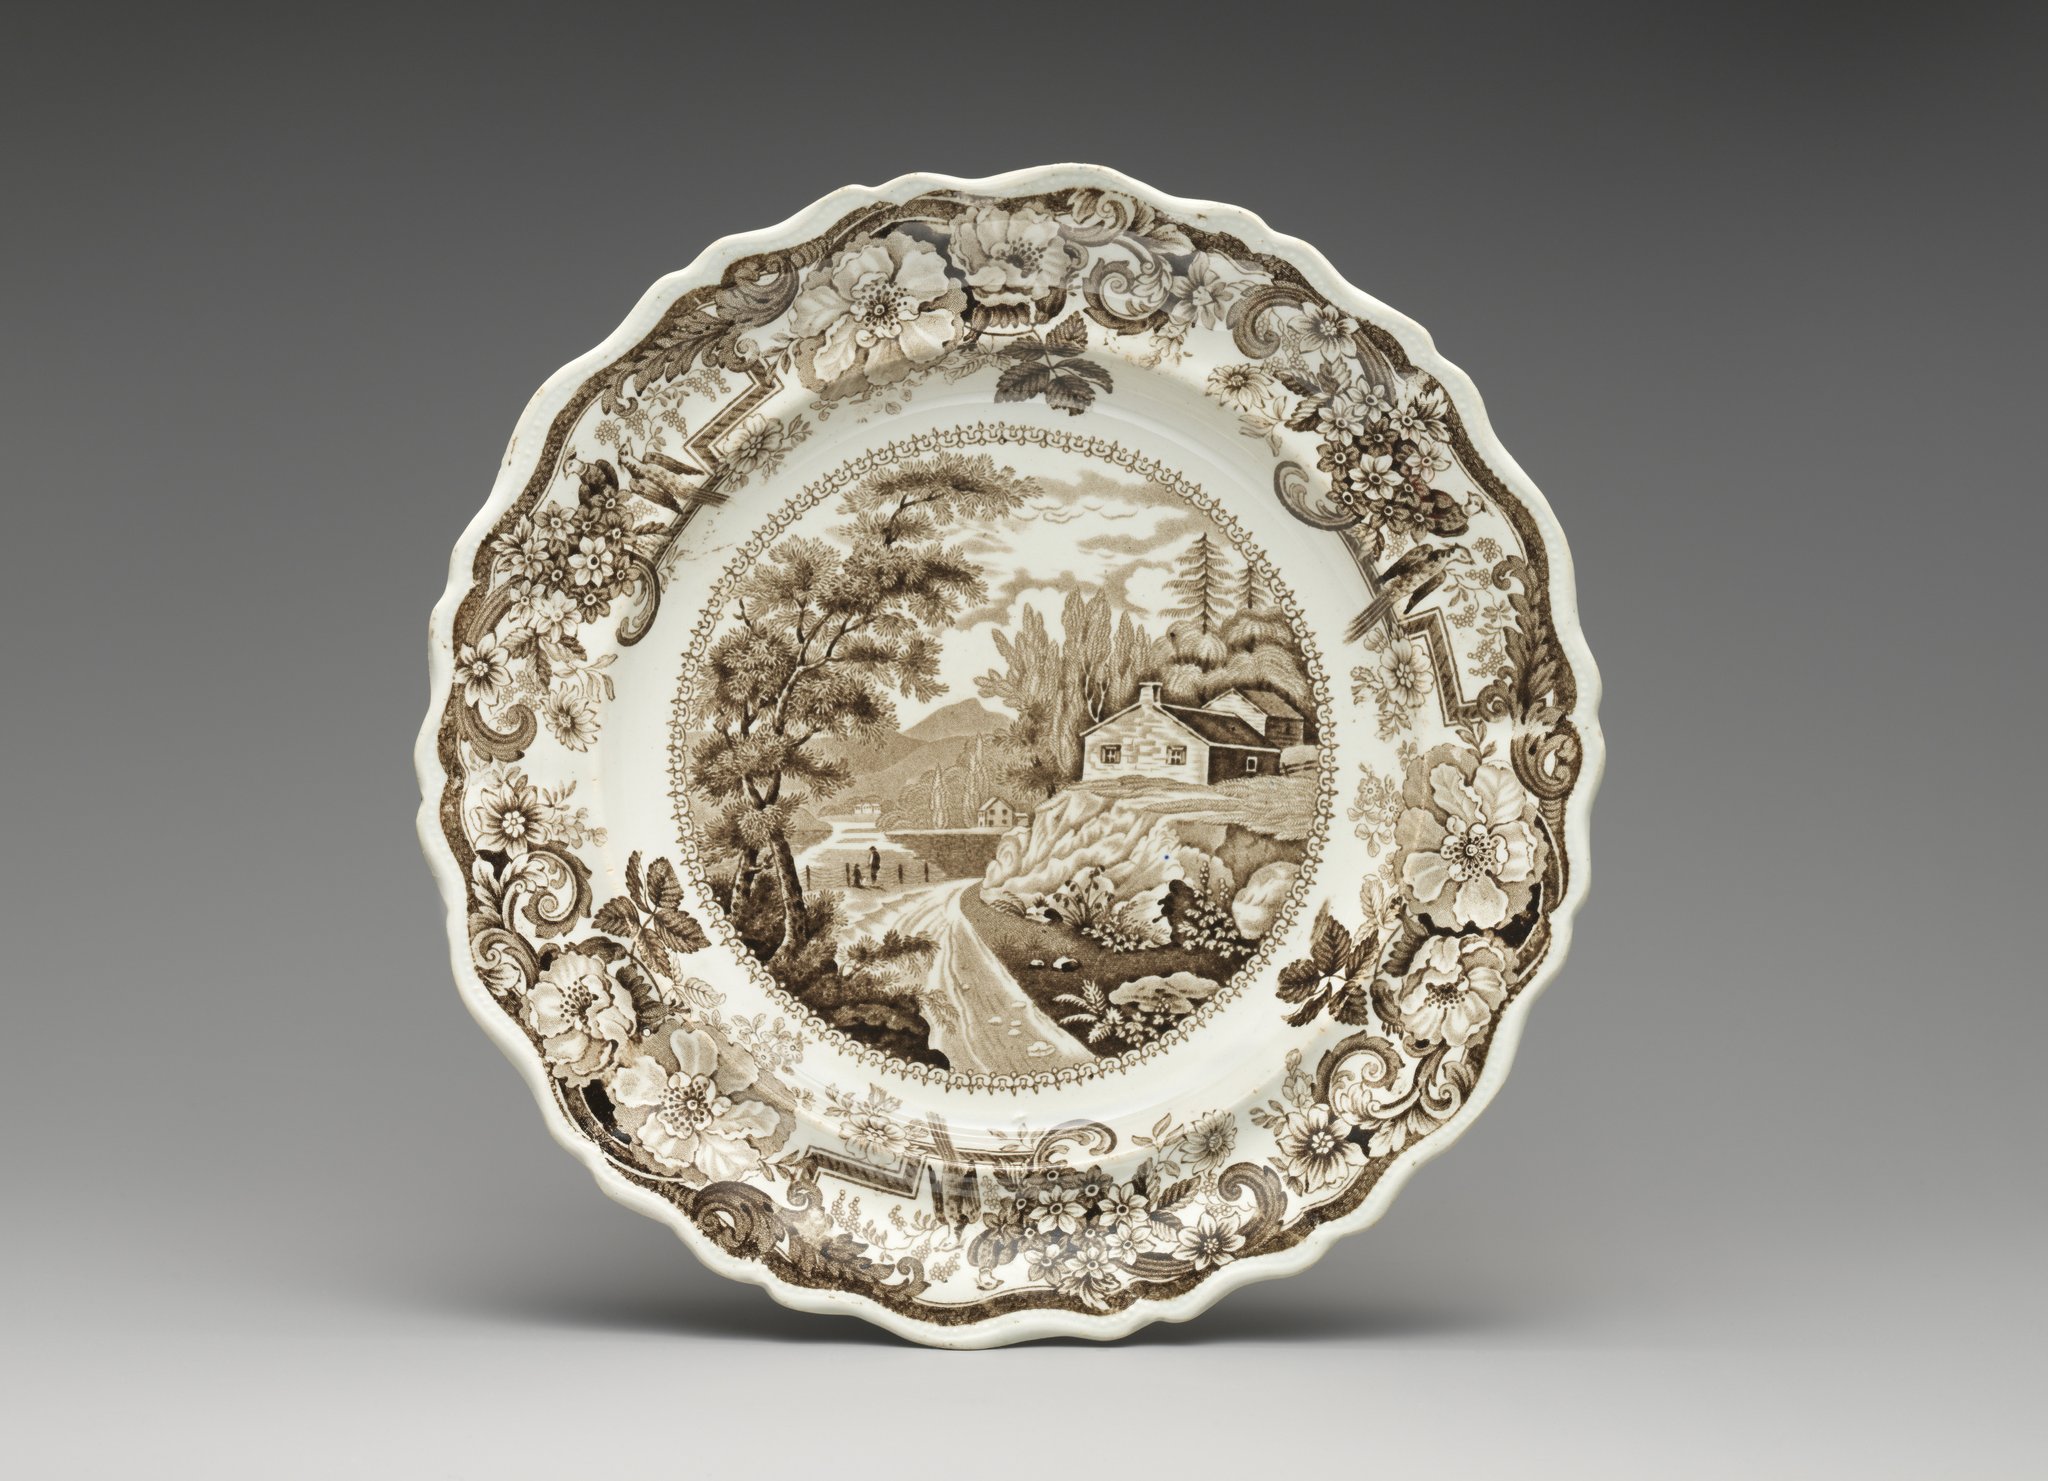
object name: plate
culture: british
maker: james and ralph clews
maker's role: maker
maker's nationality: british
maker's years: 1813-1836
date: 1823-1834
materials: earthenware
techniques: transfer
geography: england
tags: landscapes